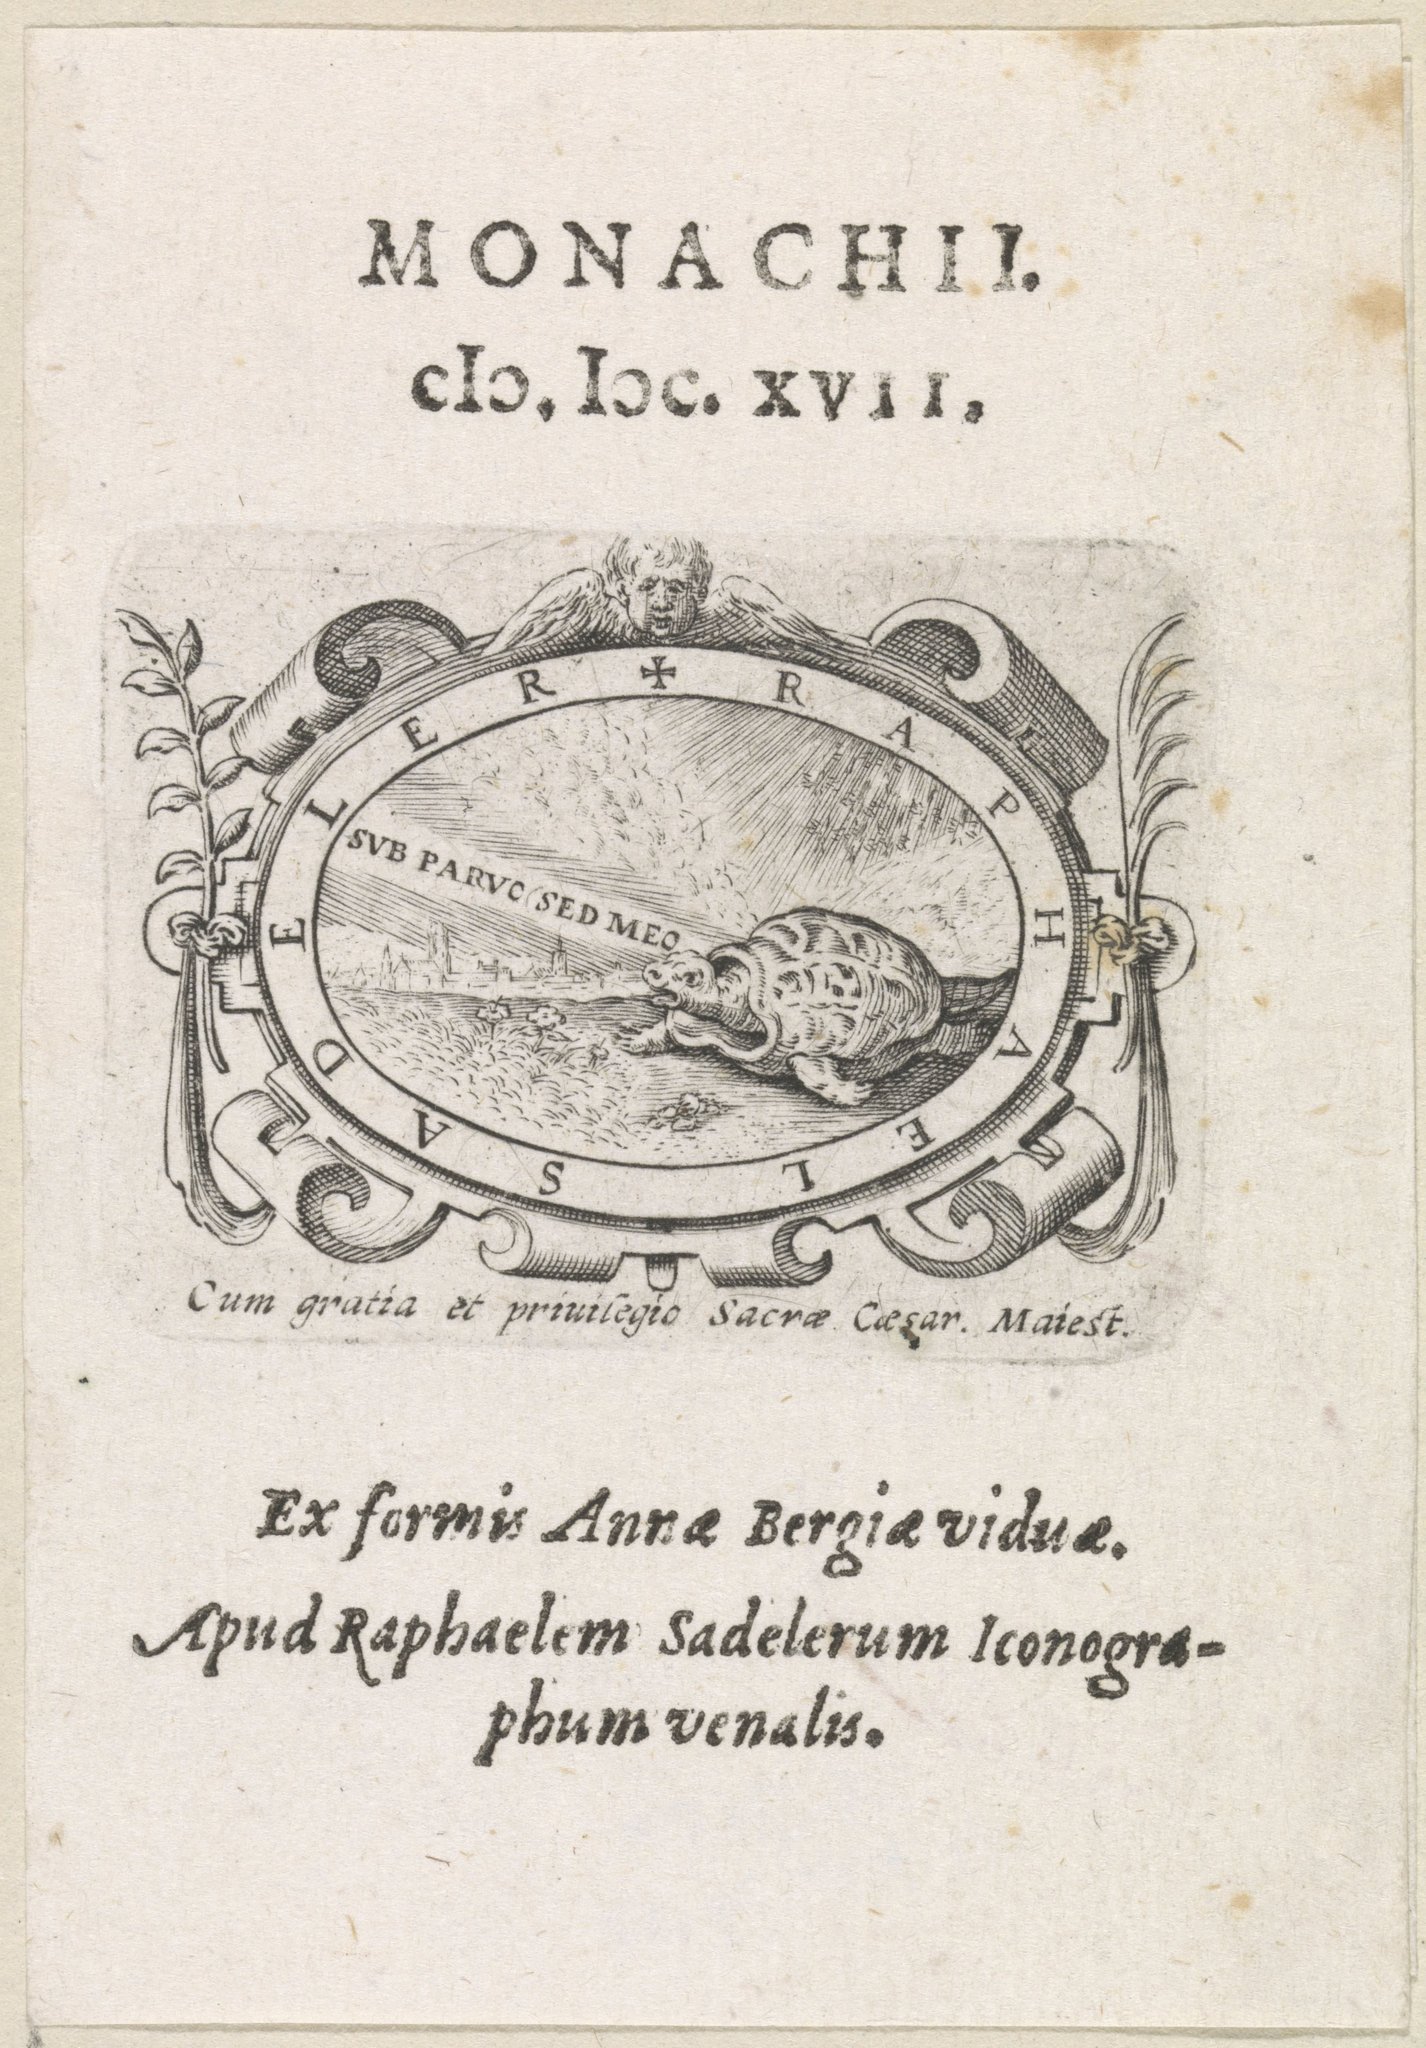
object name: printer's mark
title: Schildpad in een ovale omlijsting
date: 1617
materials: paper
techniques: engraving, letterpress printing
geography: munich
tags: tortoises, turtles, device (trade-mark of printer or publisher)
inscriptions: collector's mark: Lugt 240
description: Een ovale omlijsting met een schildpad in een landschap en het motto: "sub parvus sed meo". Dit is het drukkersmerk van Raphaël Sadeler.